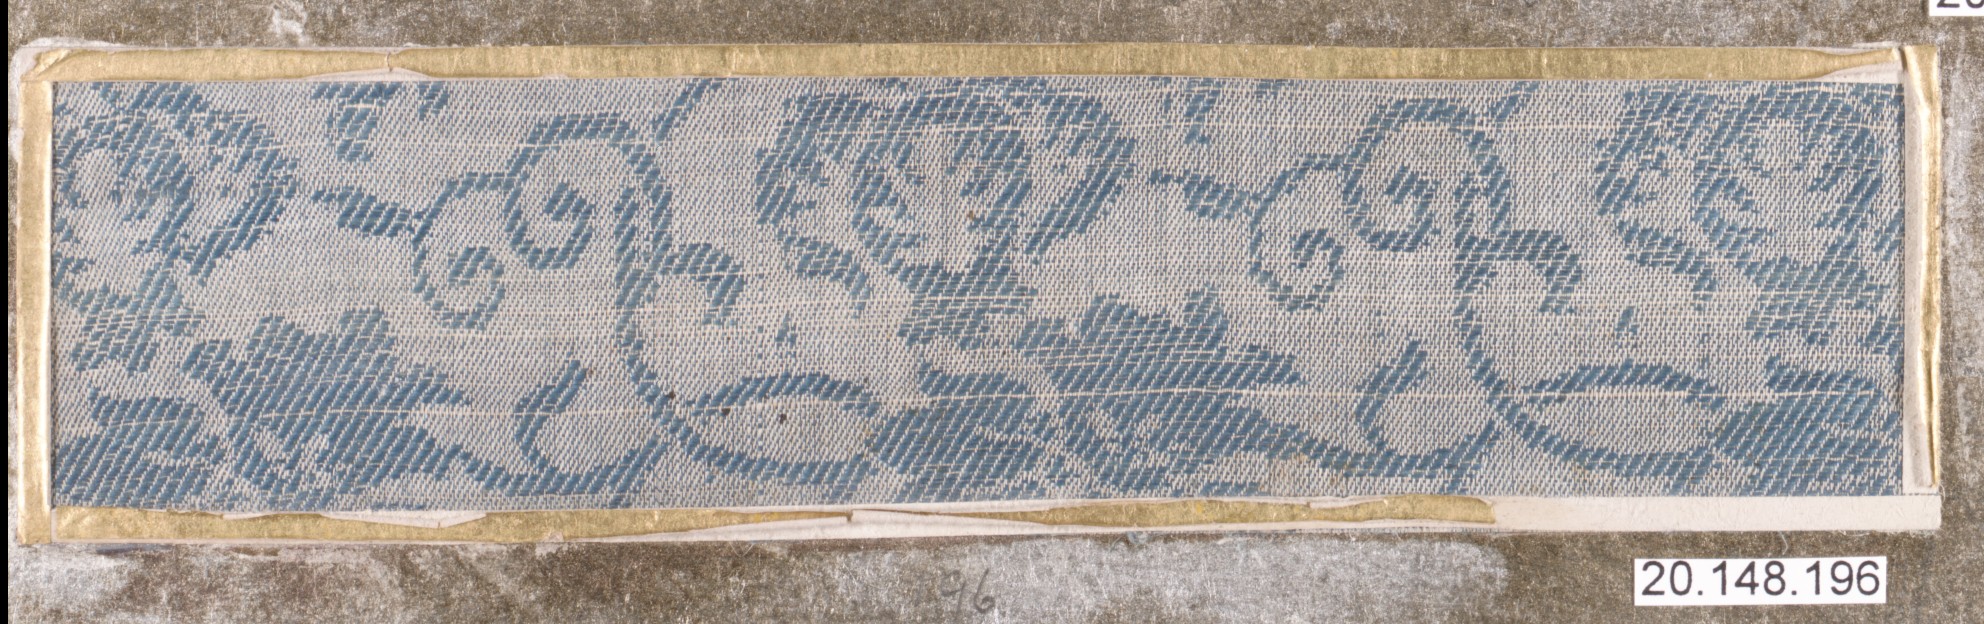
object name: piece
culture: japanese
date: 1601-1700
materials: silk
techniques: compound weave